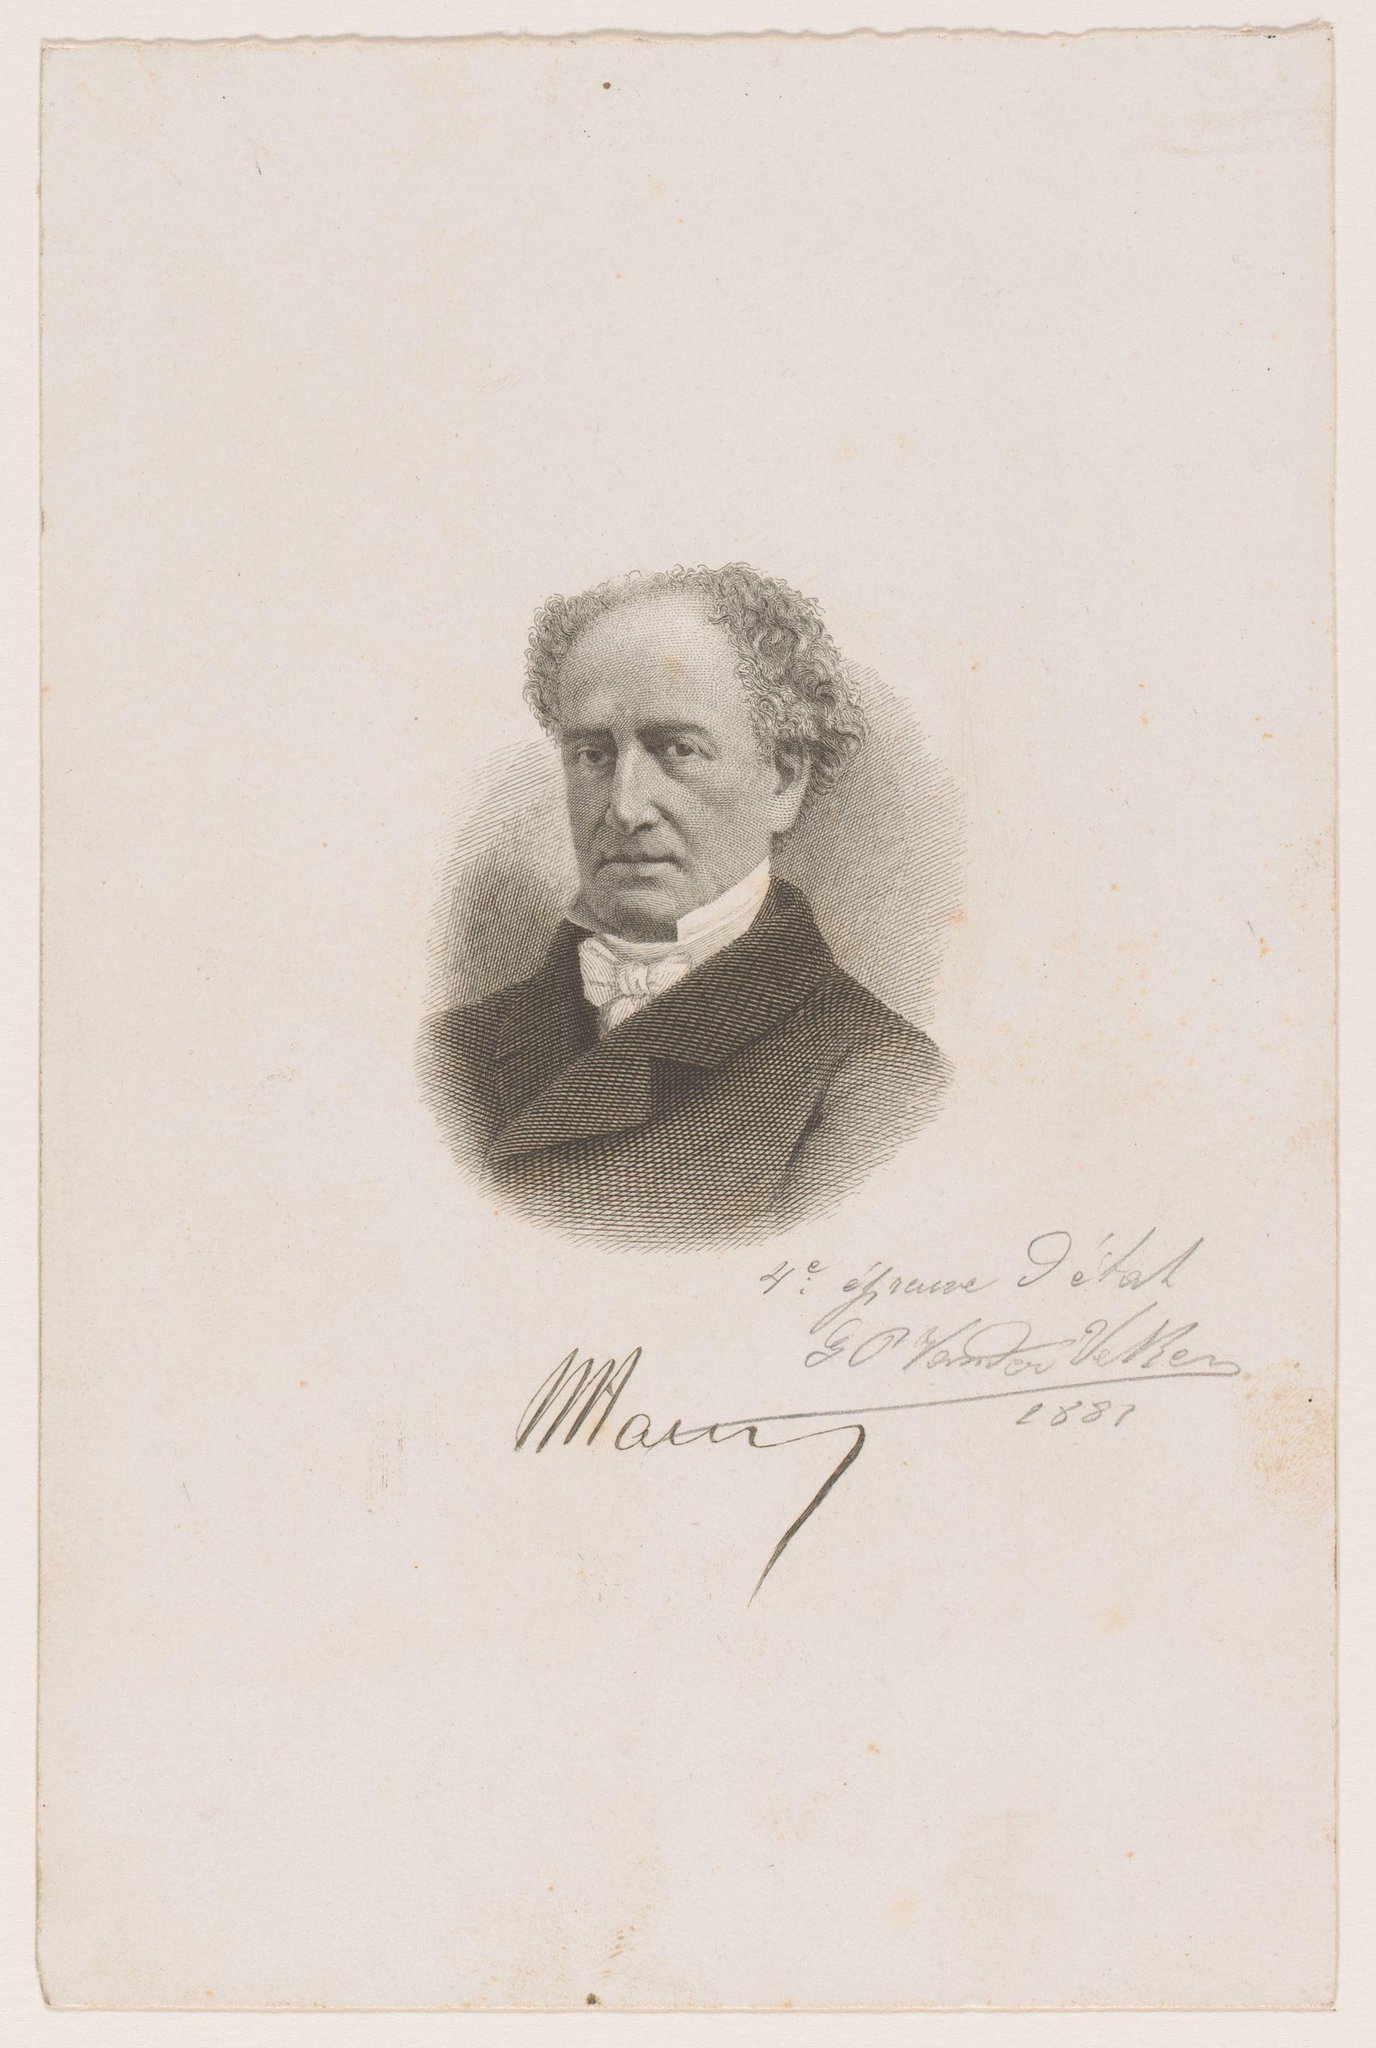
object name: print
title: Portret van een onbekende man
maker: willem philip van der veken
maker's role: print maker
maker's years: 1863-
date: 1881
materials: paper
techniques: engraving, etching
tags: adult man, historical persons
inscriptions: inscription: ‘4e epreuve d'etat’, collector's mark: Lugt 2228